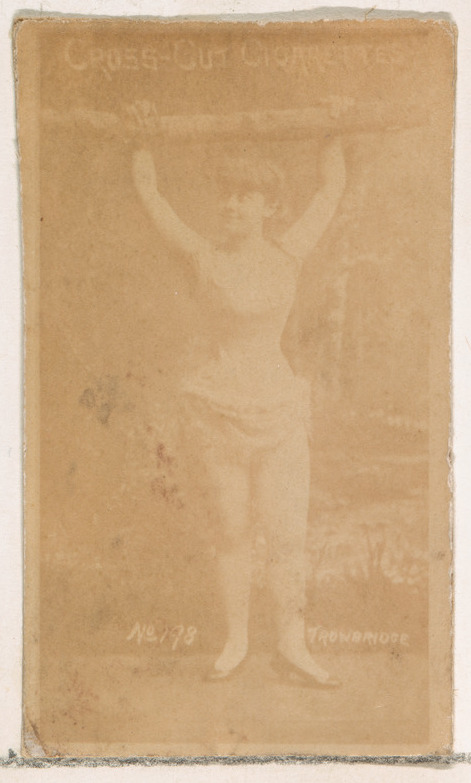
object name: print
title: Card Number 129, Trowbridge, from the Actors and Actresses series (N145-1) issued by Duke Sons & Co. to promote Cross Cut Cigarettes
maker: w. duke, sons & co.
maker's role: publisher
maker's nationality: american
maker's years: 1870-1920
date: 1880-1889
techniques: albumen silver print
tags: portraits,women,actresses